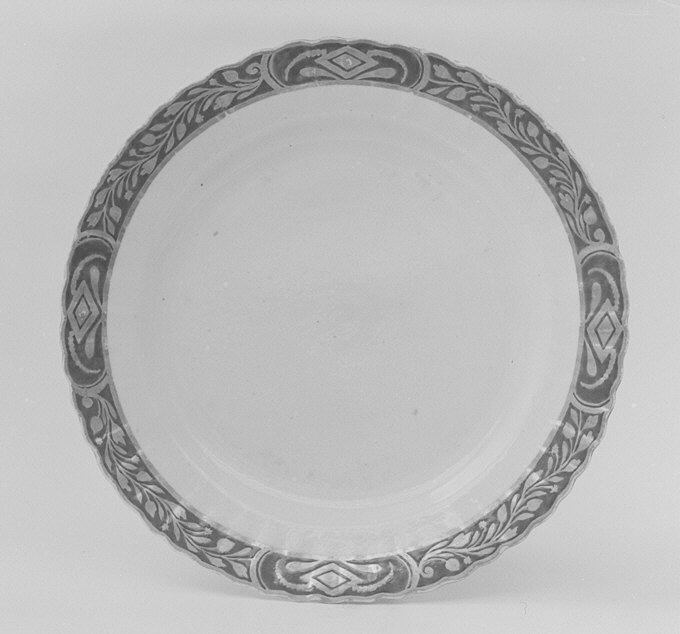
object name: plate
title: Plate (part of a service)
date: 1785-1800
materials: hard paste porcelain